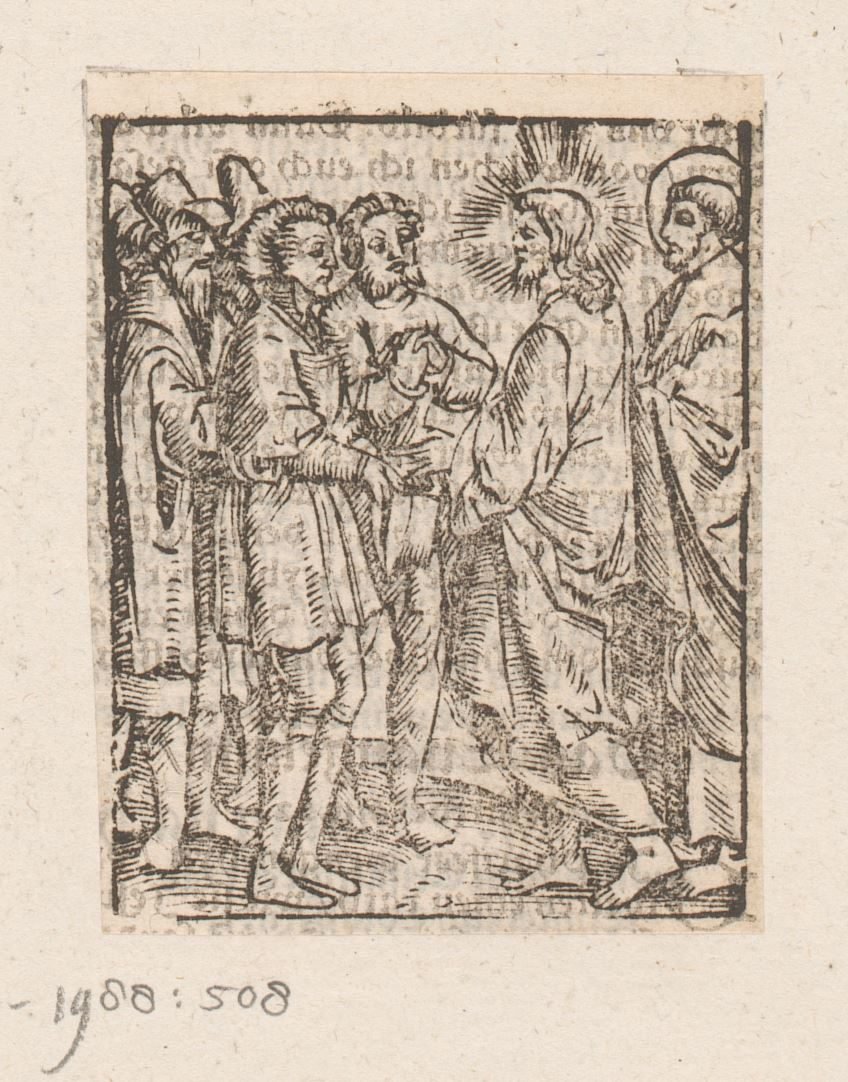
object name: book illustration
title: Christus spekend met de Joden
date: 1536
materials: paper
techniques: woodcut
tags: christ preaching or teaching (in general)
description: Prent afkomstig uit: Evangelia und Epistel. Neurenberg: Hans Guldenmund, 1536.